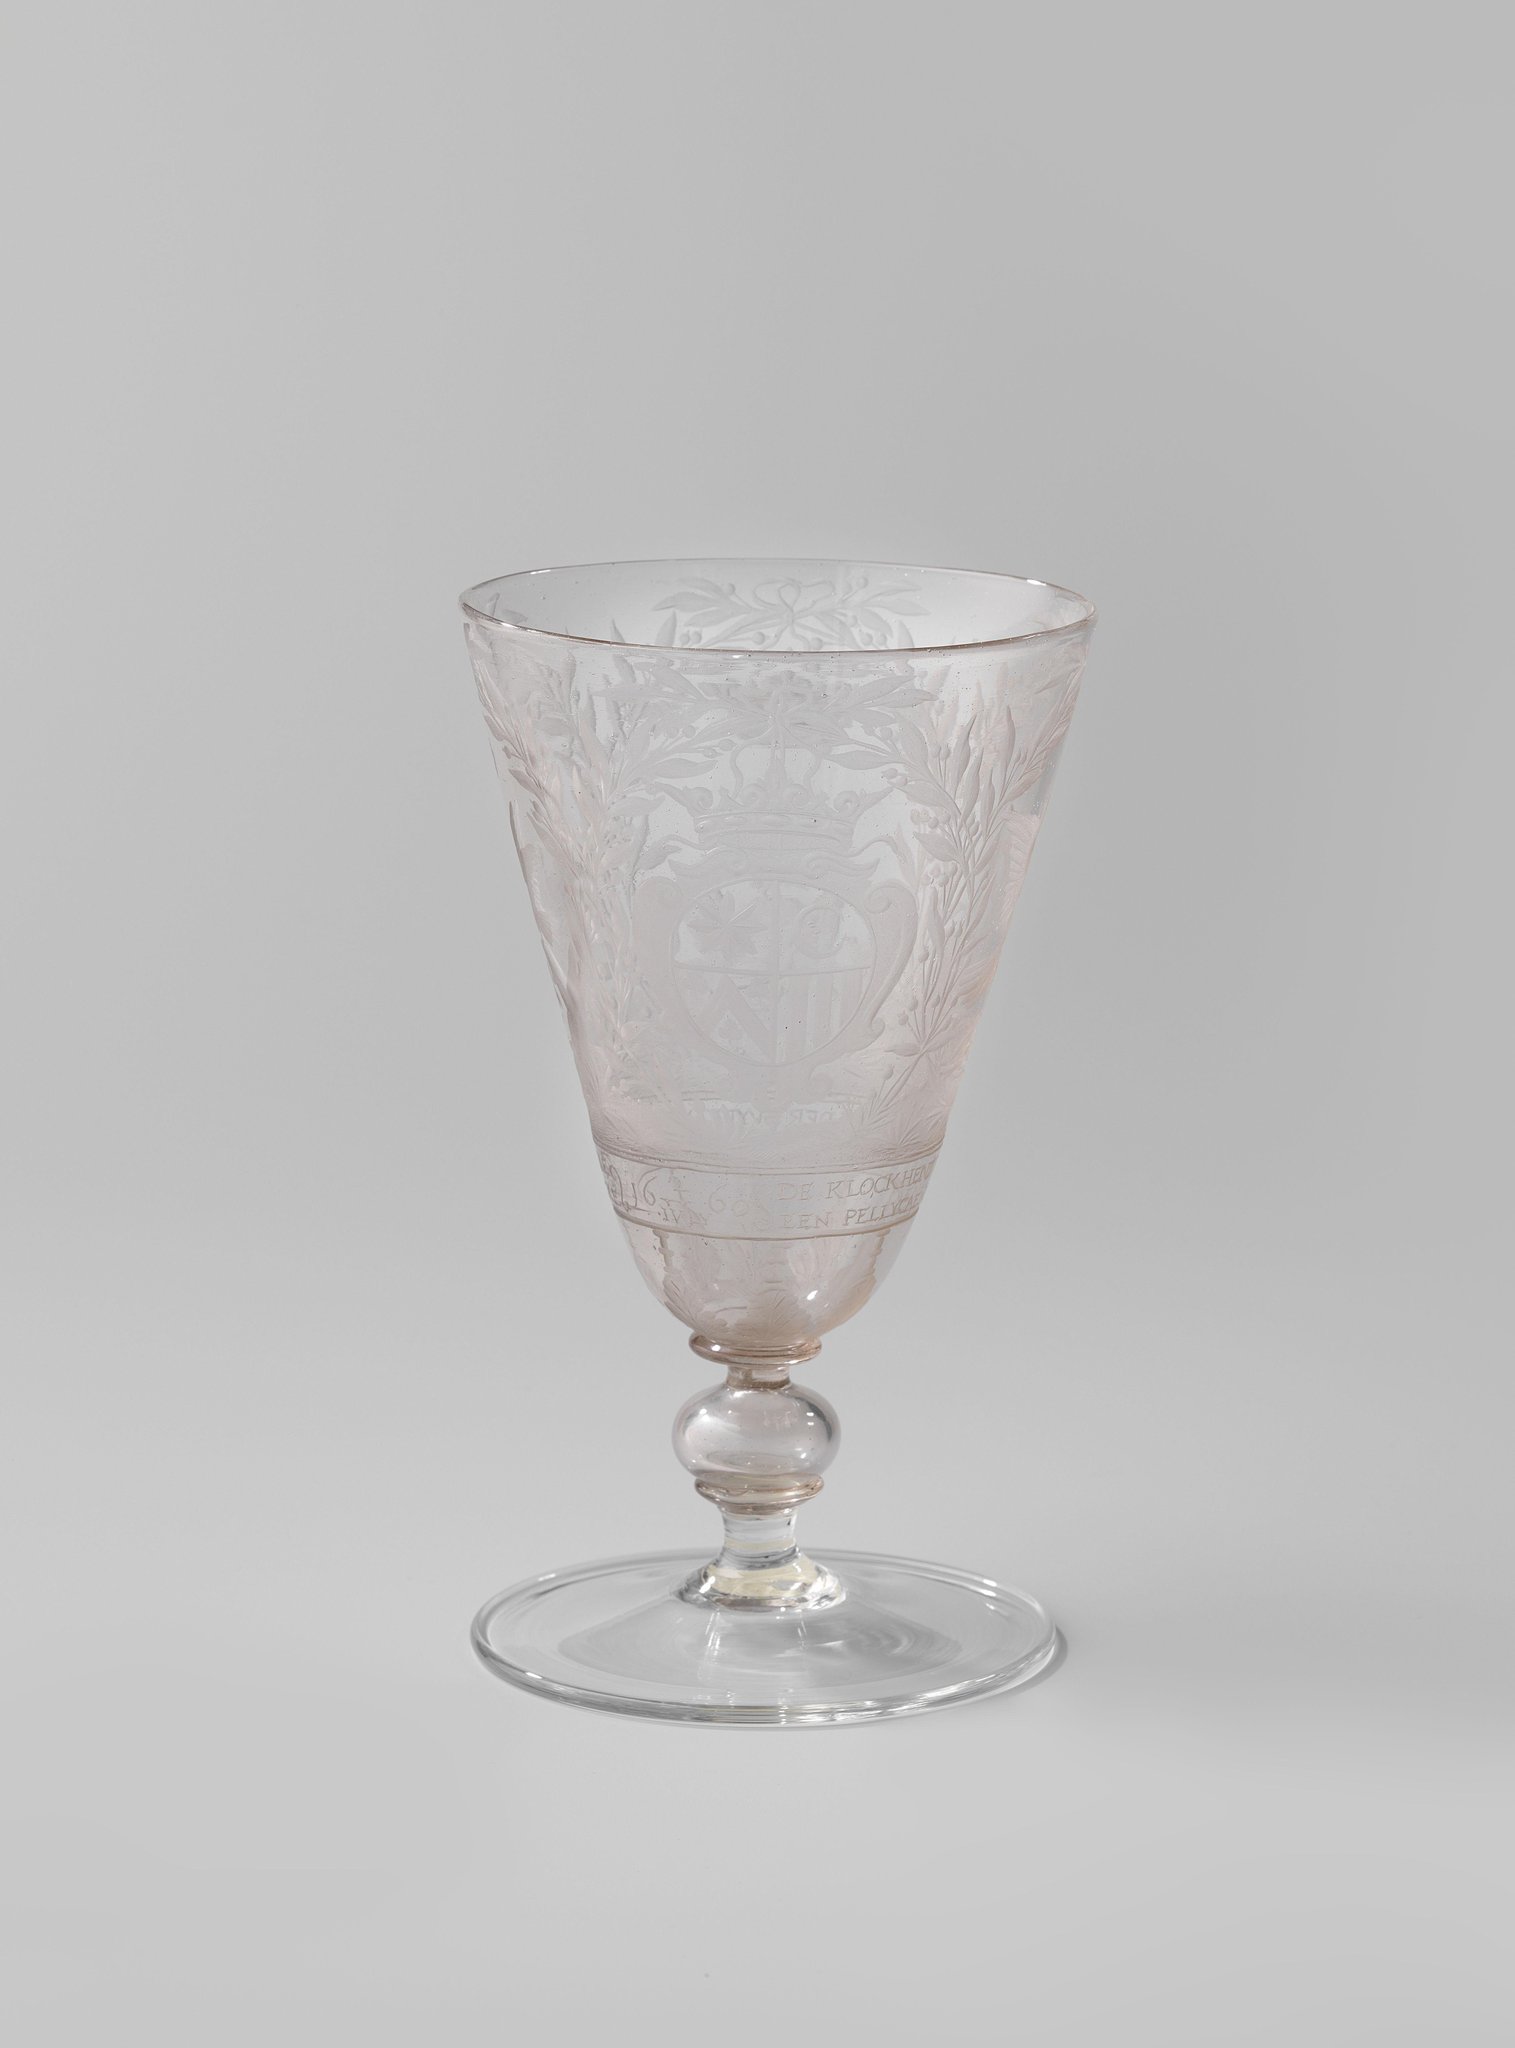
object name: goblet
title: Kelkglas met het wapen van de familie Hinlopen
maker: Anonymous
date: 1660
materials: glass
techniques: façon de venise, glassblowing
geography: low countries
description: Platte voet met omgeslagen rand. Holle balusterstam met twee schijven. Conische kelk met afgeronde bodem. Op de kelk het gekroonde wapen van de Amsterdamse familie Hinlopen, een pelikaan die haar jongen voedt, een kloek met kuikens en twee tortelduiven op een tak. Met opschrift in doorlopende band onder de voorstellingen: DE KLOCKHENS TROVWYCHEYT.DER DVYFKENS TRECKE BECKE.EEN PELLYCAENSCHE HERT CAN ONS TOT DVUCHT OP WECKE. Gedateerd 16 july 1660.